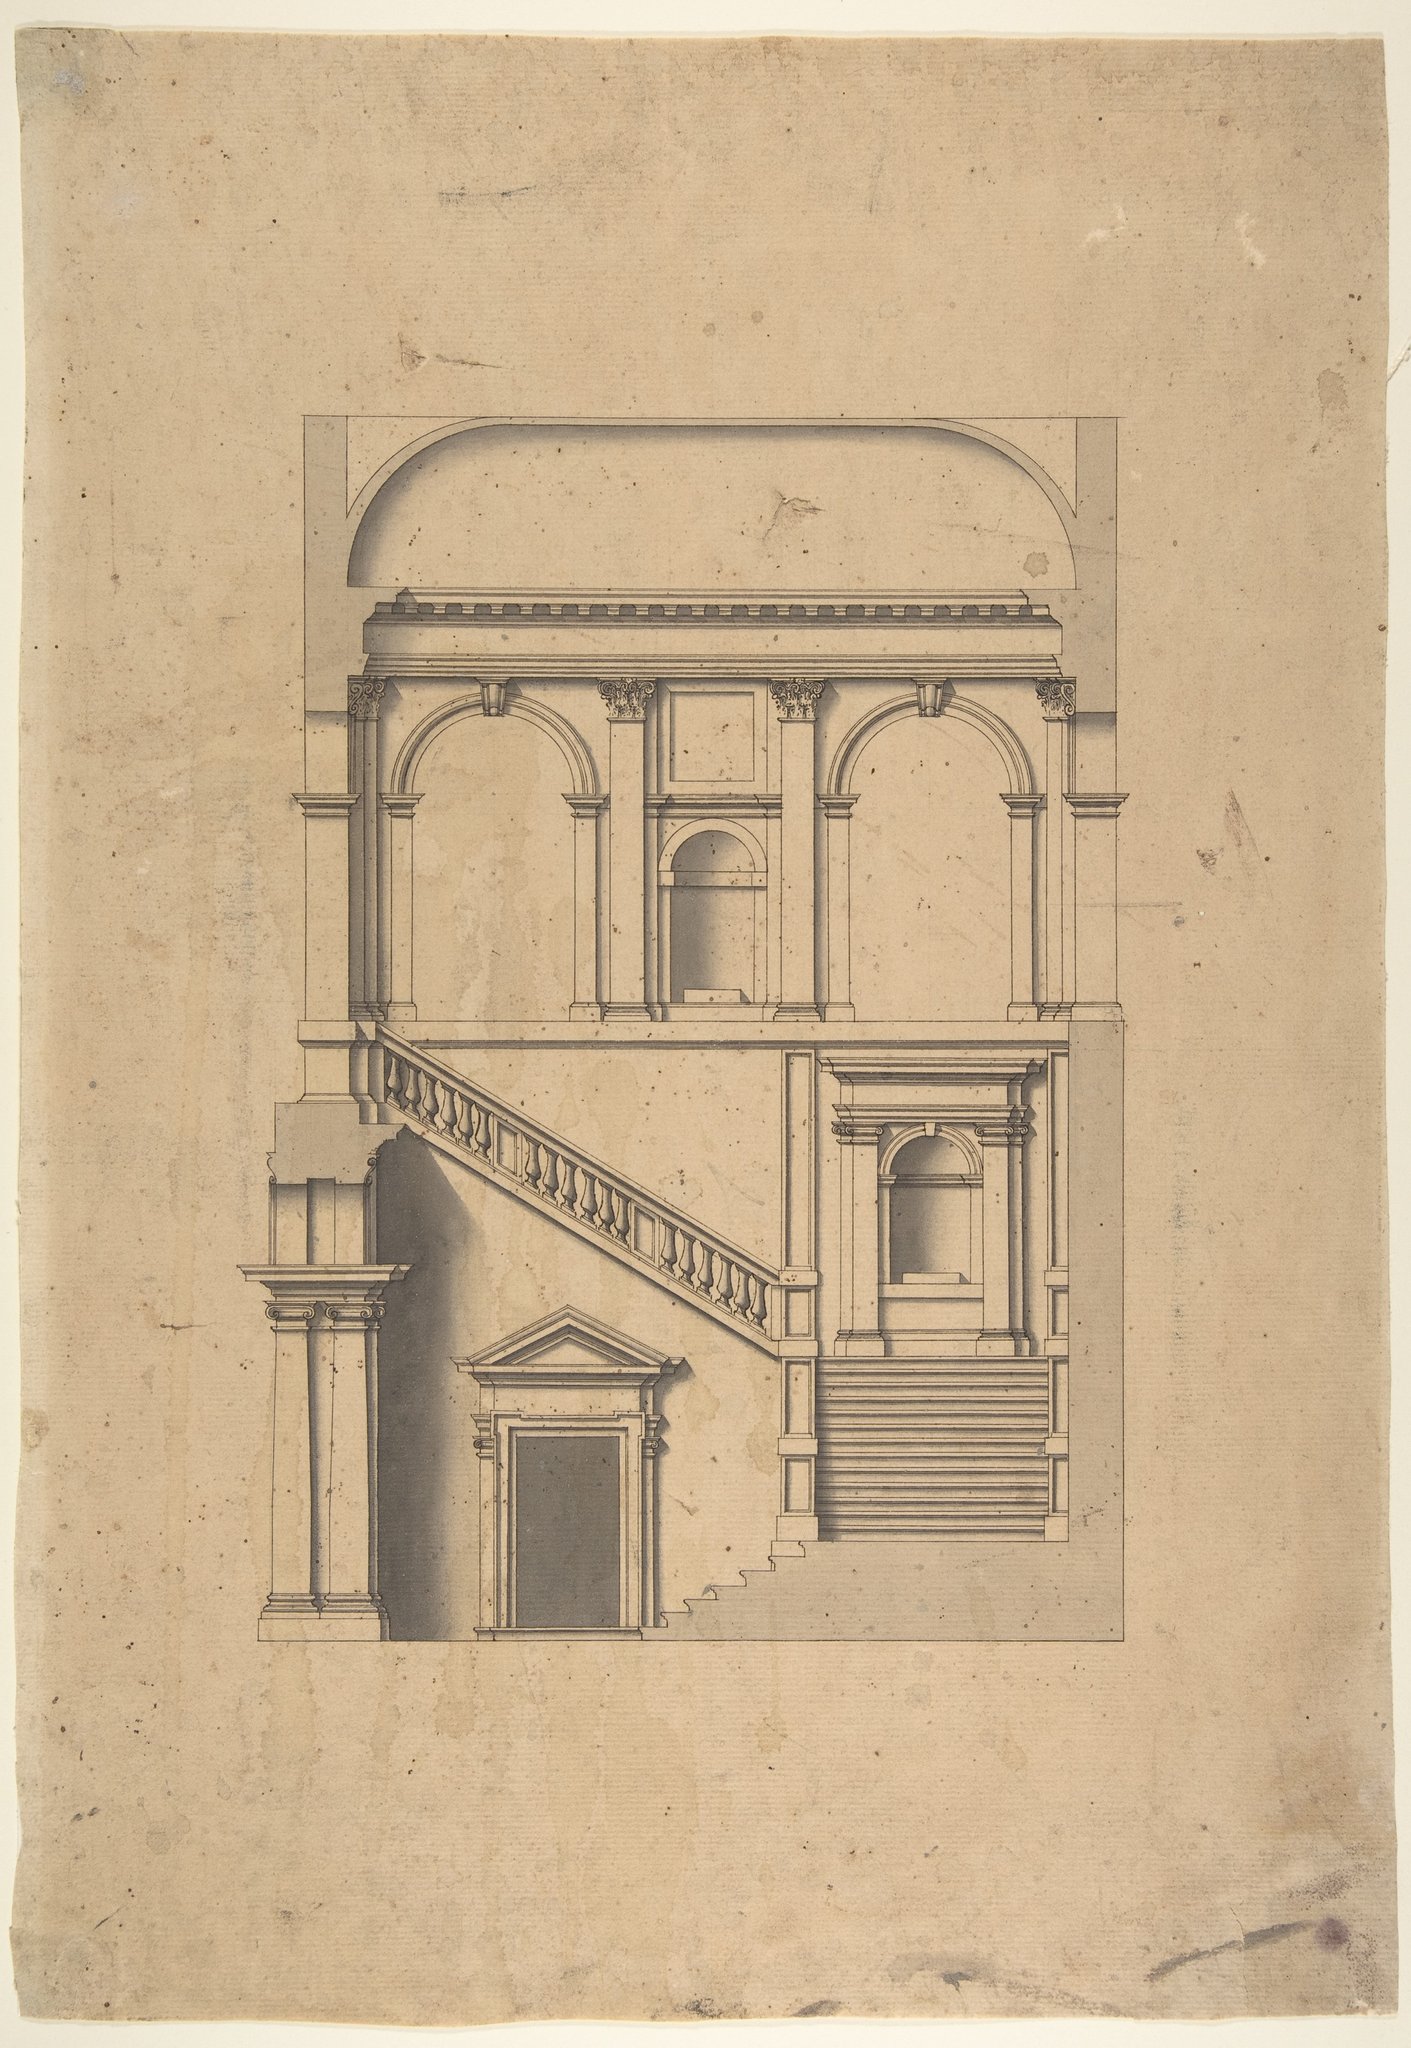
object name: drawing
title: Architectural Design in Section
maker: leonardo marini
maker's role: artist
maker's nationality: italian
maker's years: 1730-1797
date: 1701-1800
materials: ink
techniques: brush, pen, wash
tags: architecture